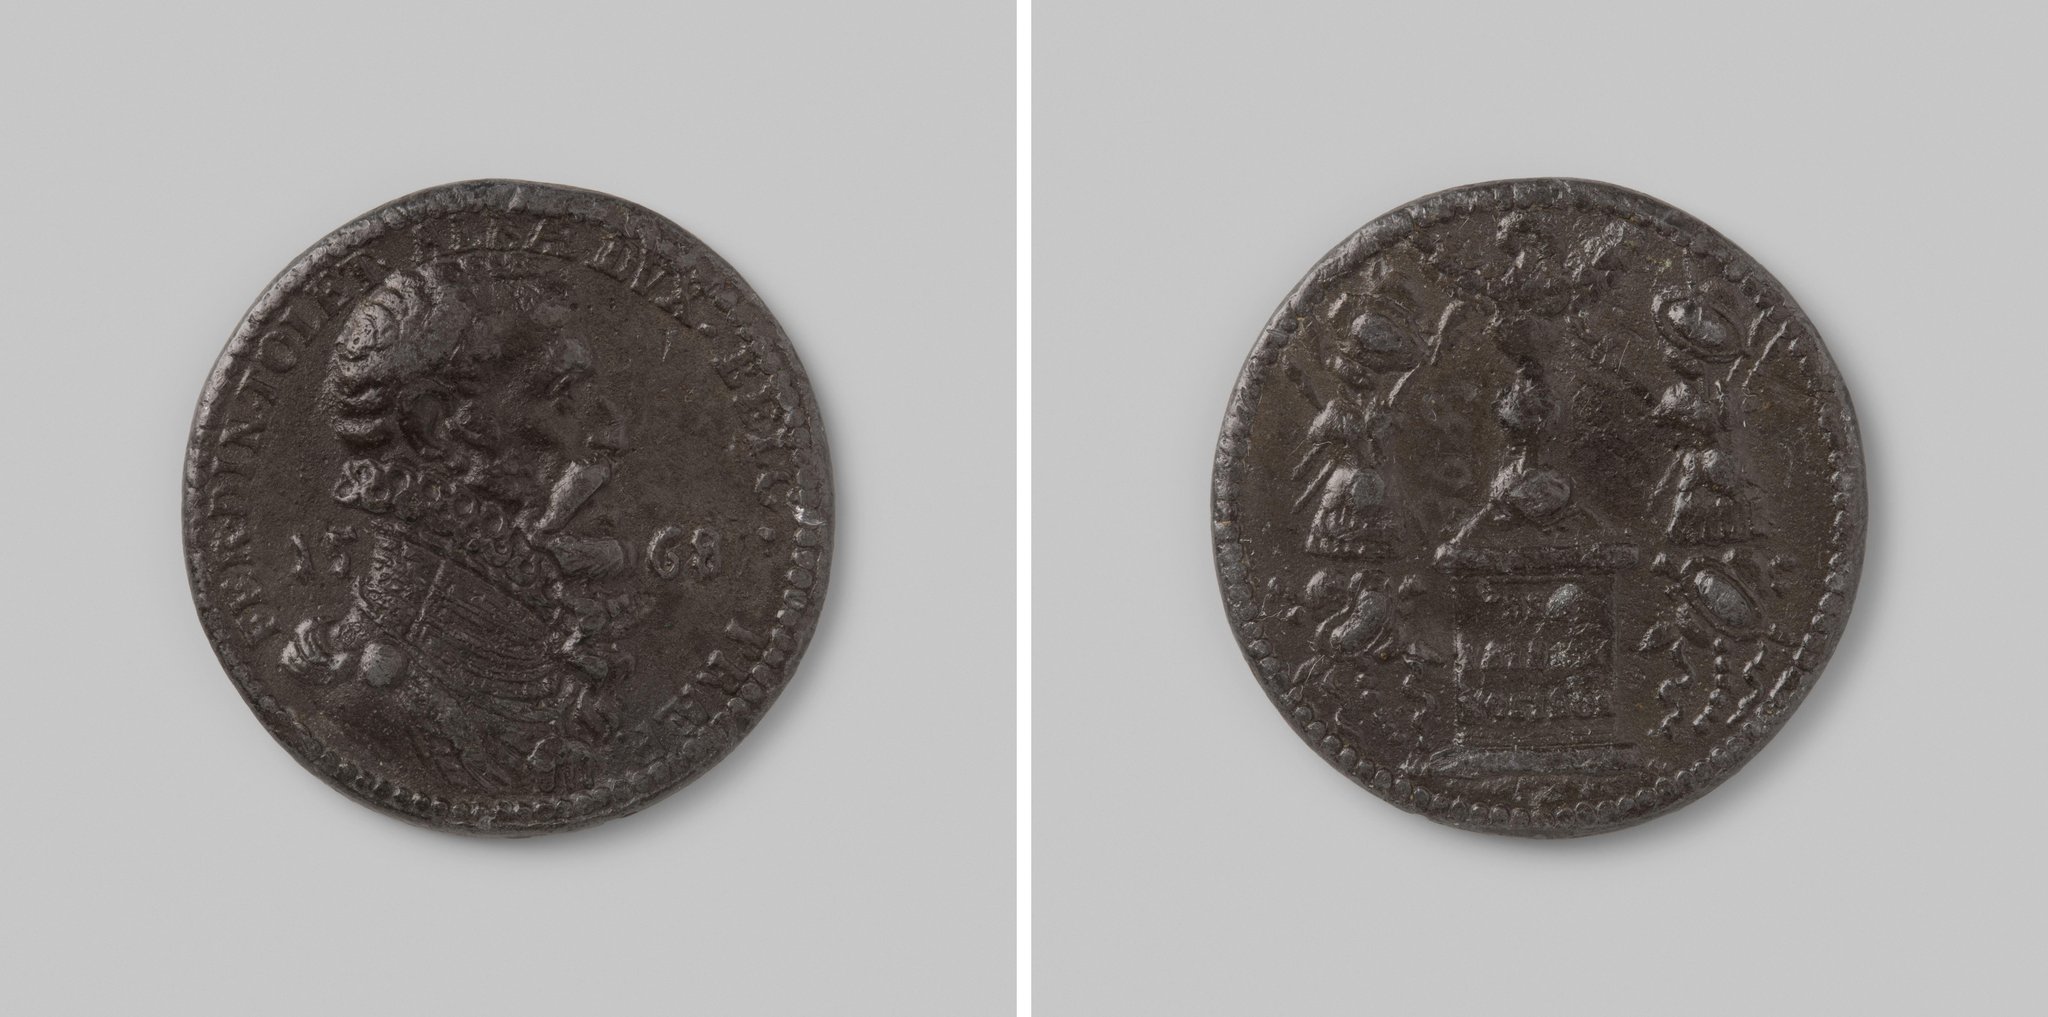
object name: copy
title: Ferdinand van Toledo, hertog van Alva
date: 1571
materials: lead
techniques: casting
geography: antwerp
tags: fernando álvarez de toledo (3rd duke of alba)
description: Loden penning. Voorzijde: borststuk man tussen jaartal binnen omschrift. Keerzijde: brandend altaar met opschrift onder lauwerkrans tussen twee wapentropheen